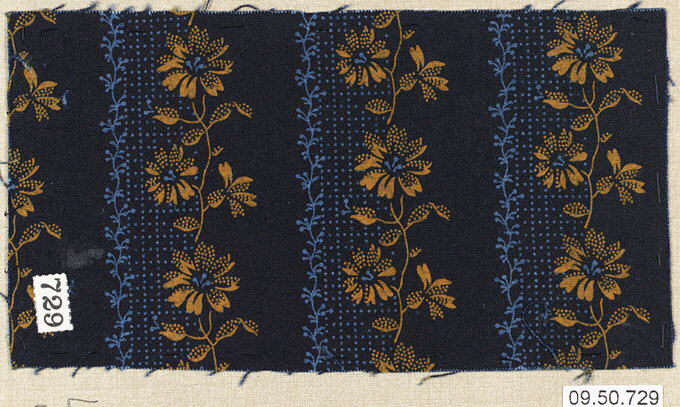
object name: piece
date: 1801-1900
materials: cotton